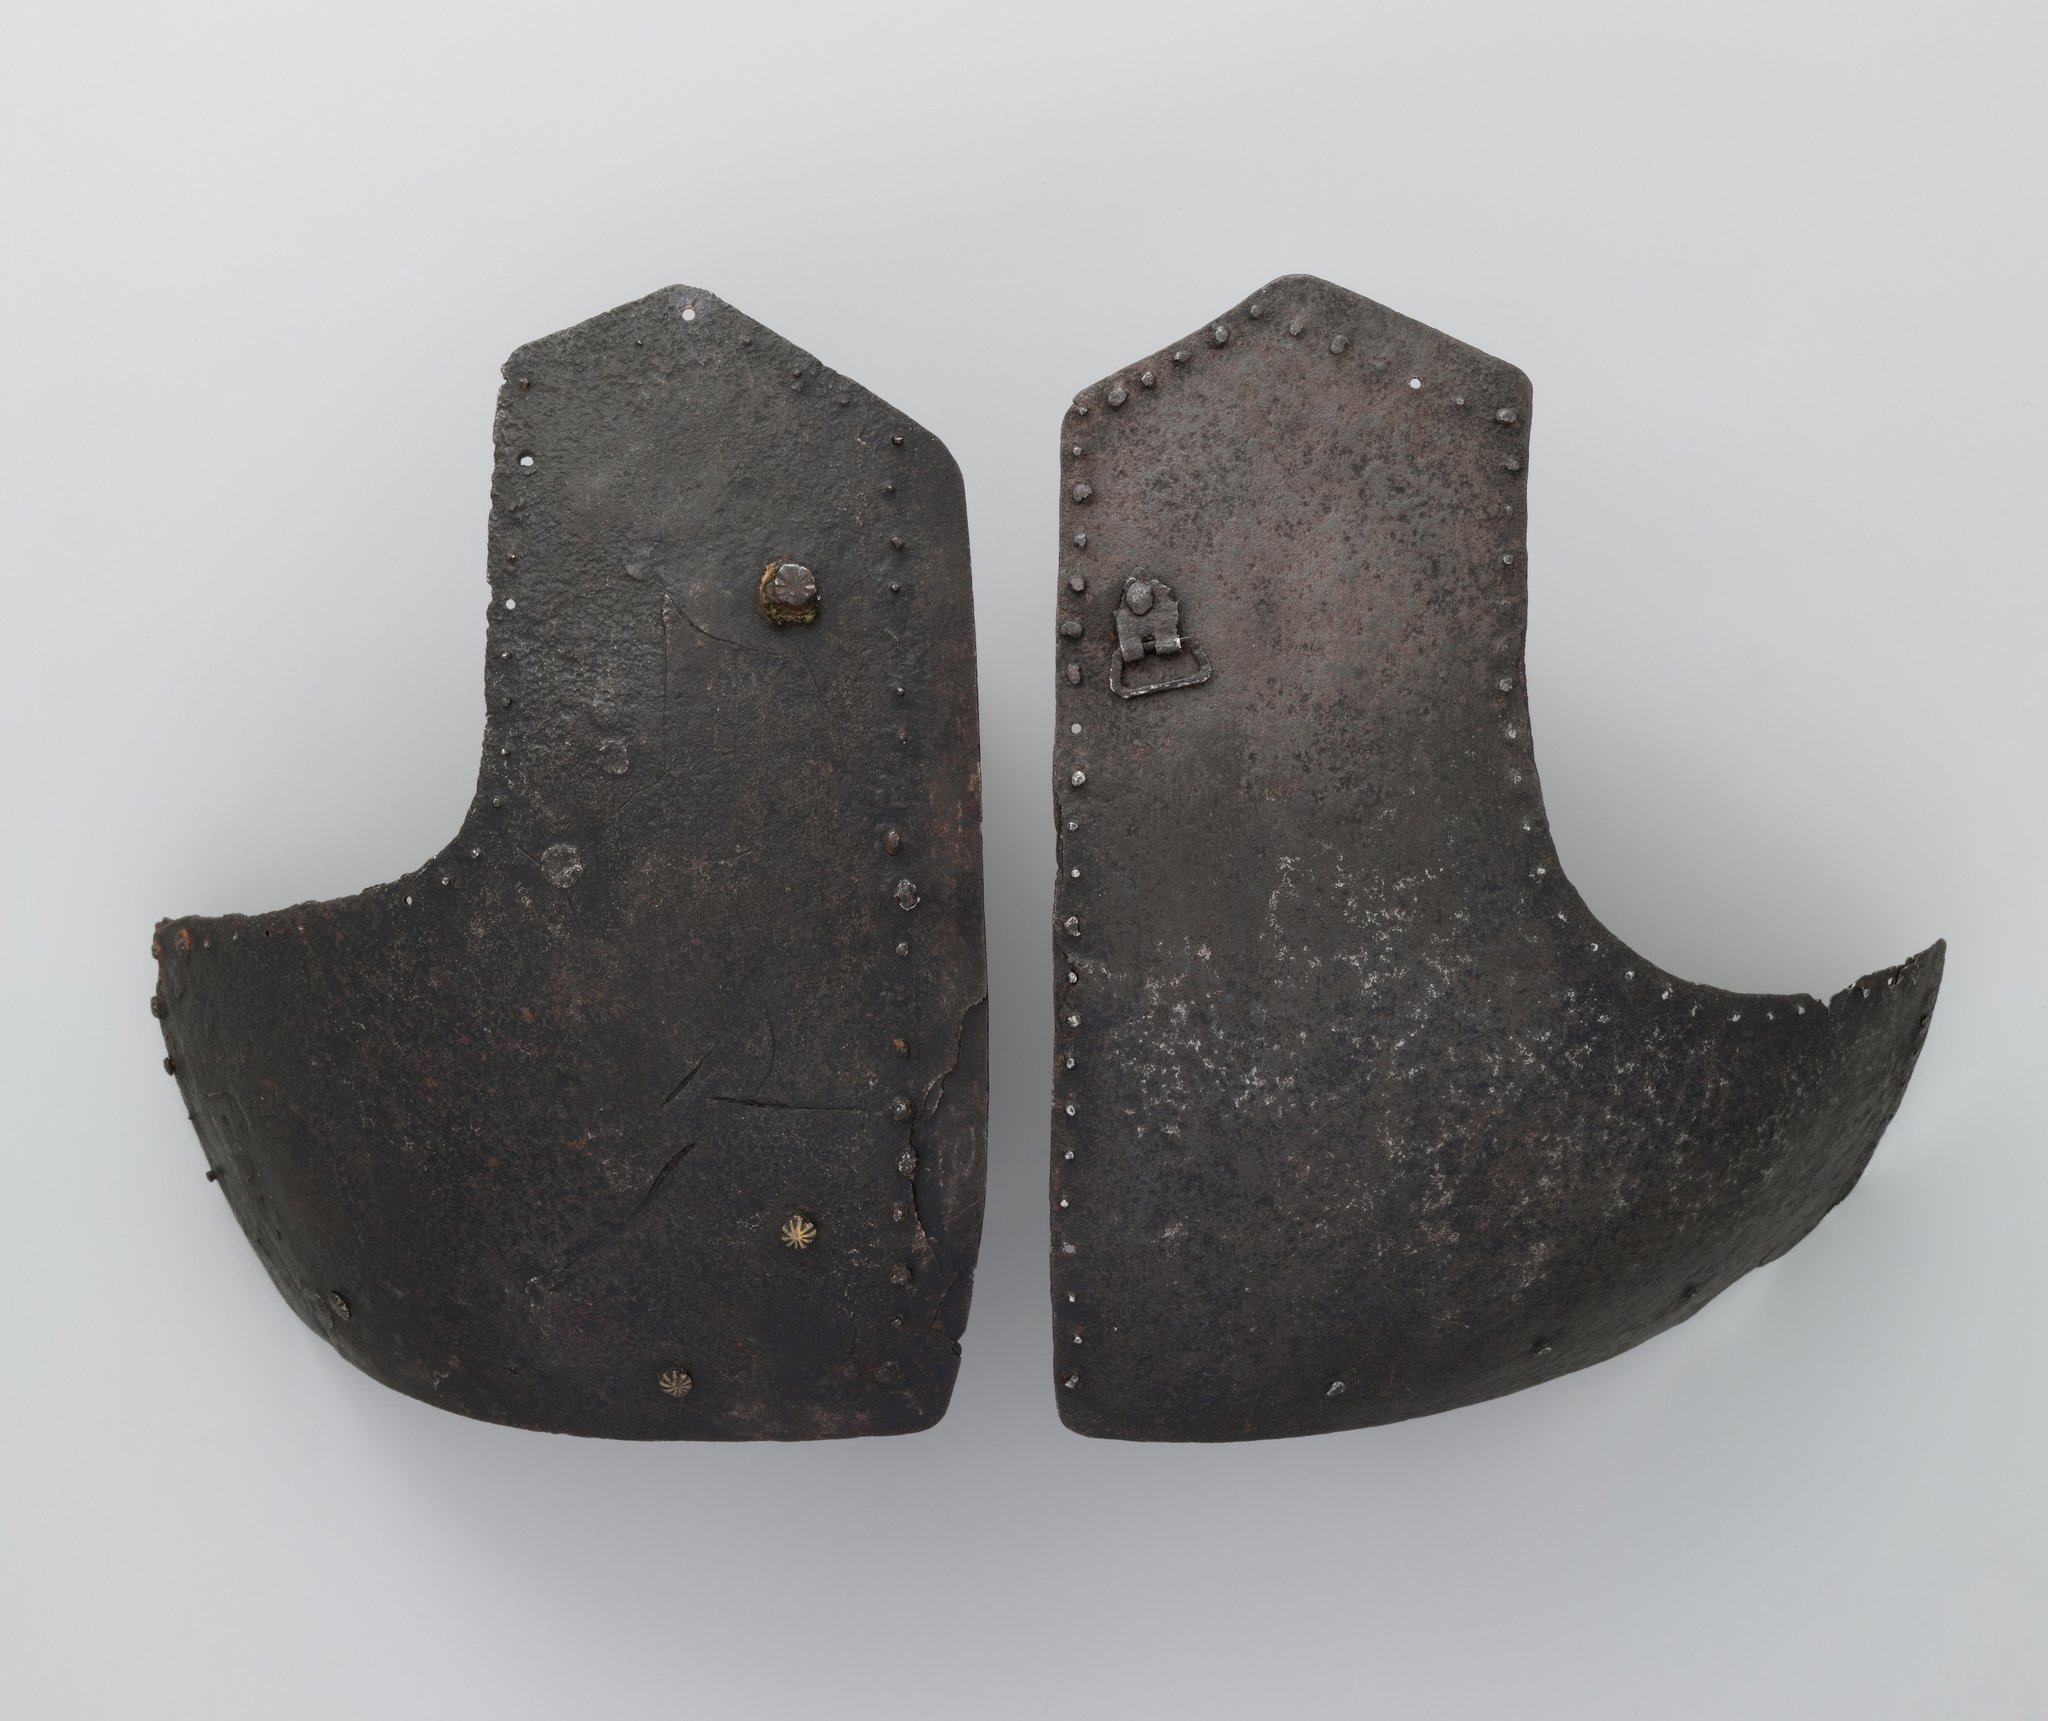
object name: right and left breastplate from a brigandine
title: Right and Left Breastplates from a Brigandine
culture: italian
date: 1400-1425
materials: copper alloy, steel, textile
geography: italy